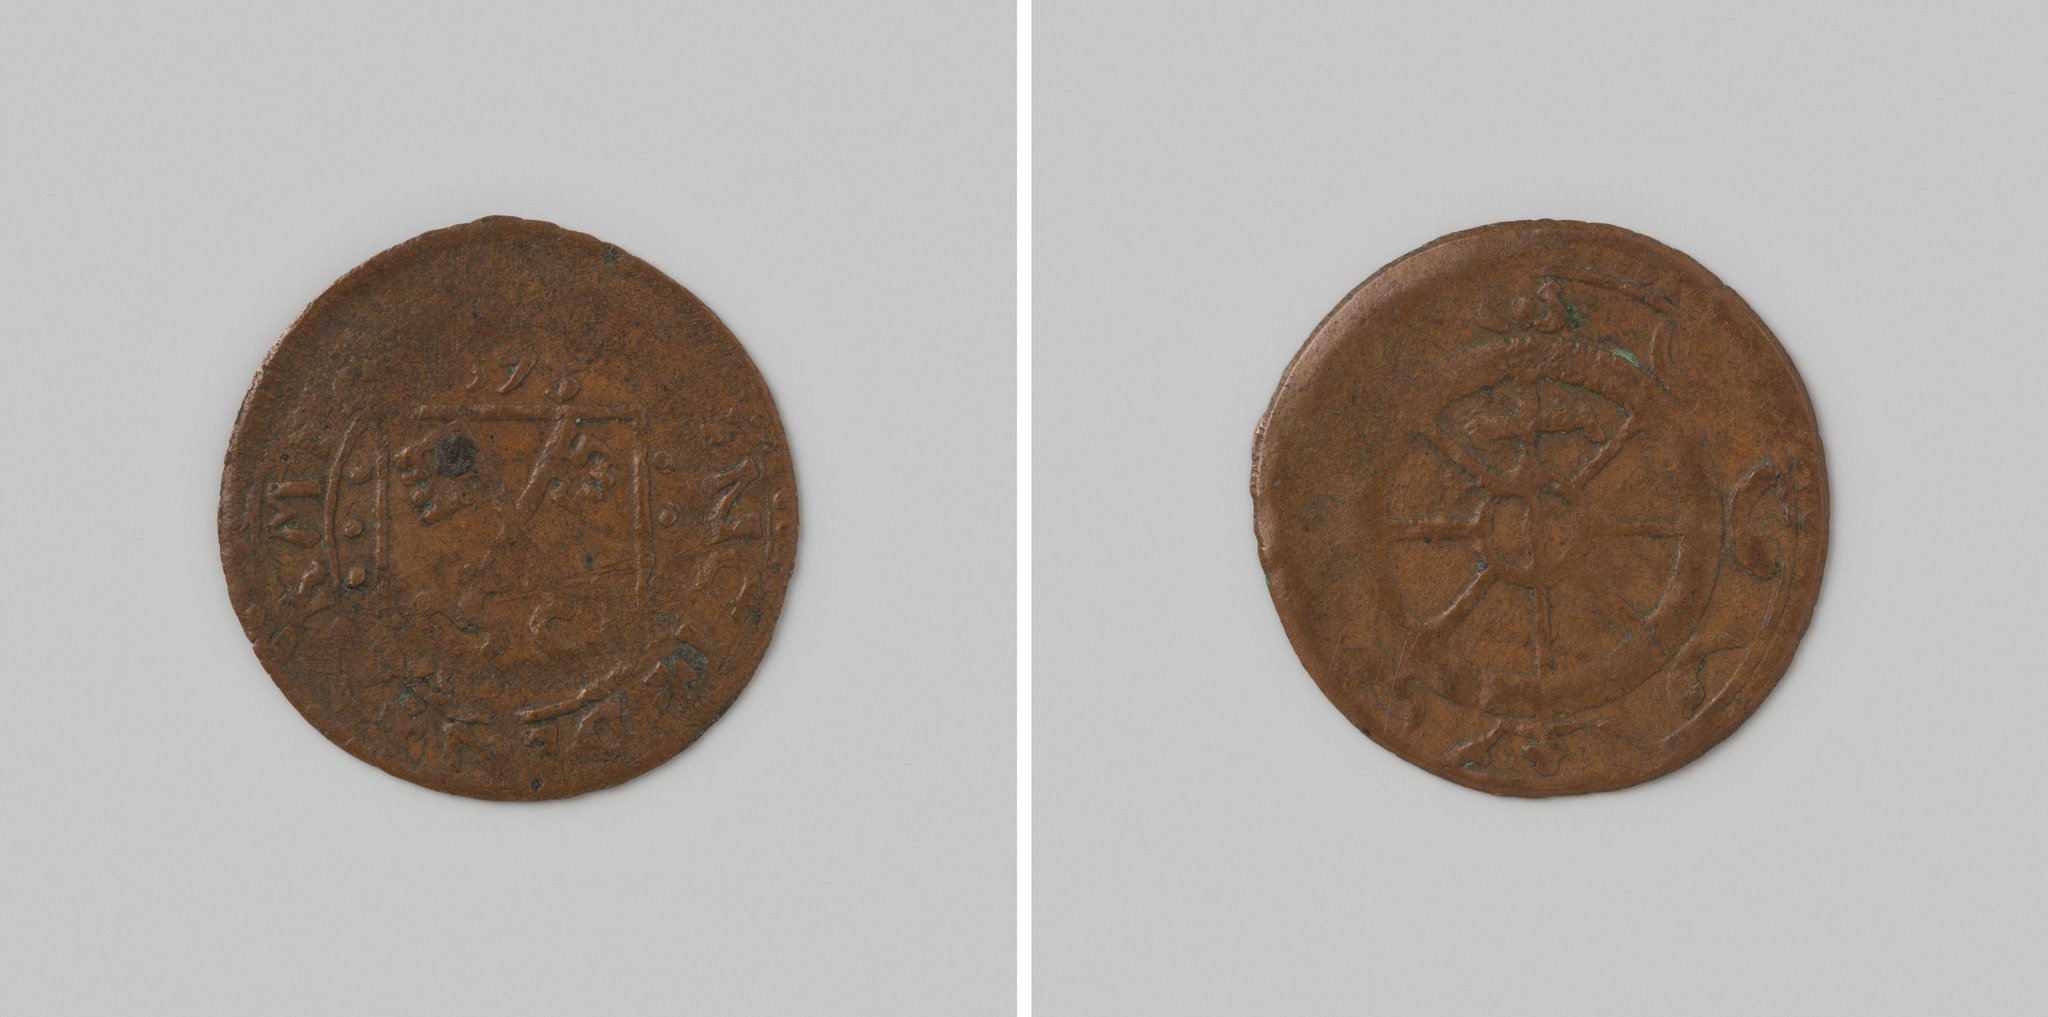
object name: oord, oortje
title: Kwart stuiver of oord, noodmunt van de stad Leiden met Sint Catharina, 1573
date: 1573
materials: copper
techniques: striking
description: Koperen noodmunt. Voorzijde: wapenschild van de stad, waarboven 1573. Omschrift: Gedenct den armen. Keerzijde: gekroond rad van Sint Catharina.